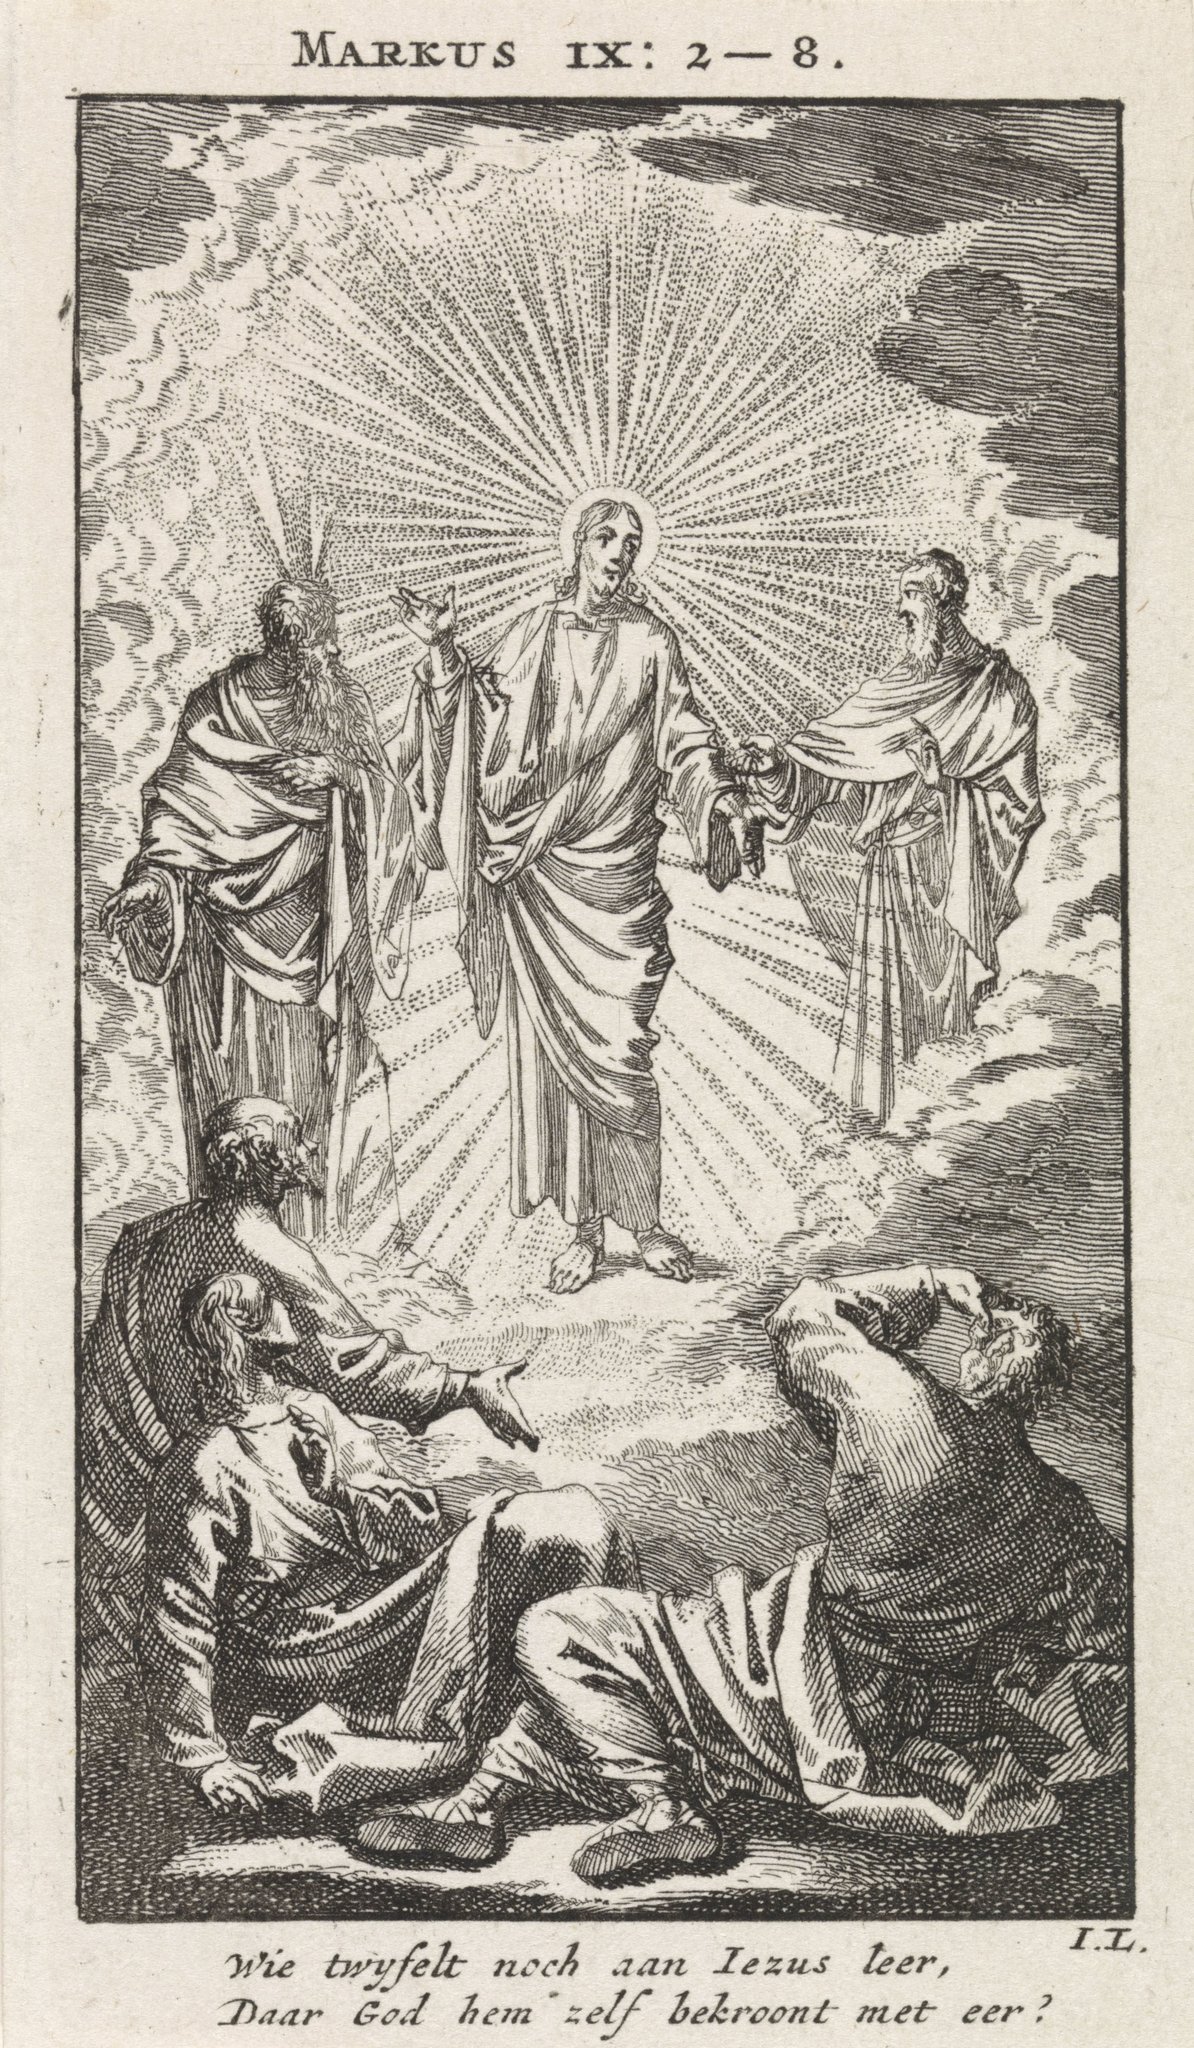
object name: print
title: Transfiguratie van Christus op de berg Tabor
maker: jan luyken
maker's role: draughtsman, print maker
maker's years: 1649-1712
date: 1712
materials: paper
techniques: etching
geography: amsterdam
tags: the transfiguration: moses and elijah appear on either side of christ on mount tabor (matthew 17:1-13; mark 9:2-13; luke 9:28-36)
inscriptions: collector's mark: Lugt 2228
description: Illustratie voor: Luyken, Jan. Bybel printen. Amsterdam: Pieter Arentsz. II (wed.) en Cornelis van der Sys, 1712, p. 23.